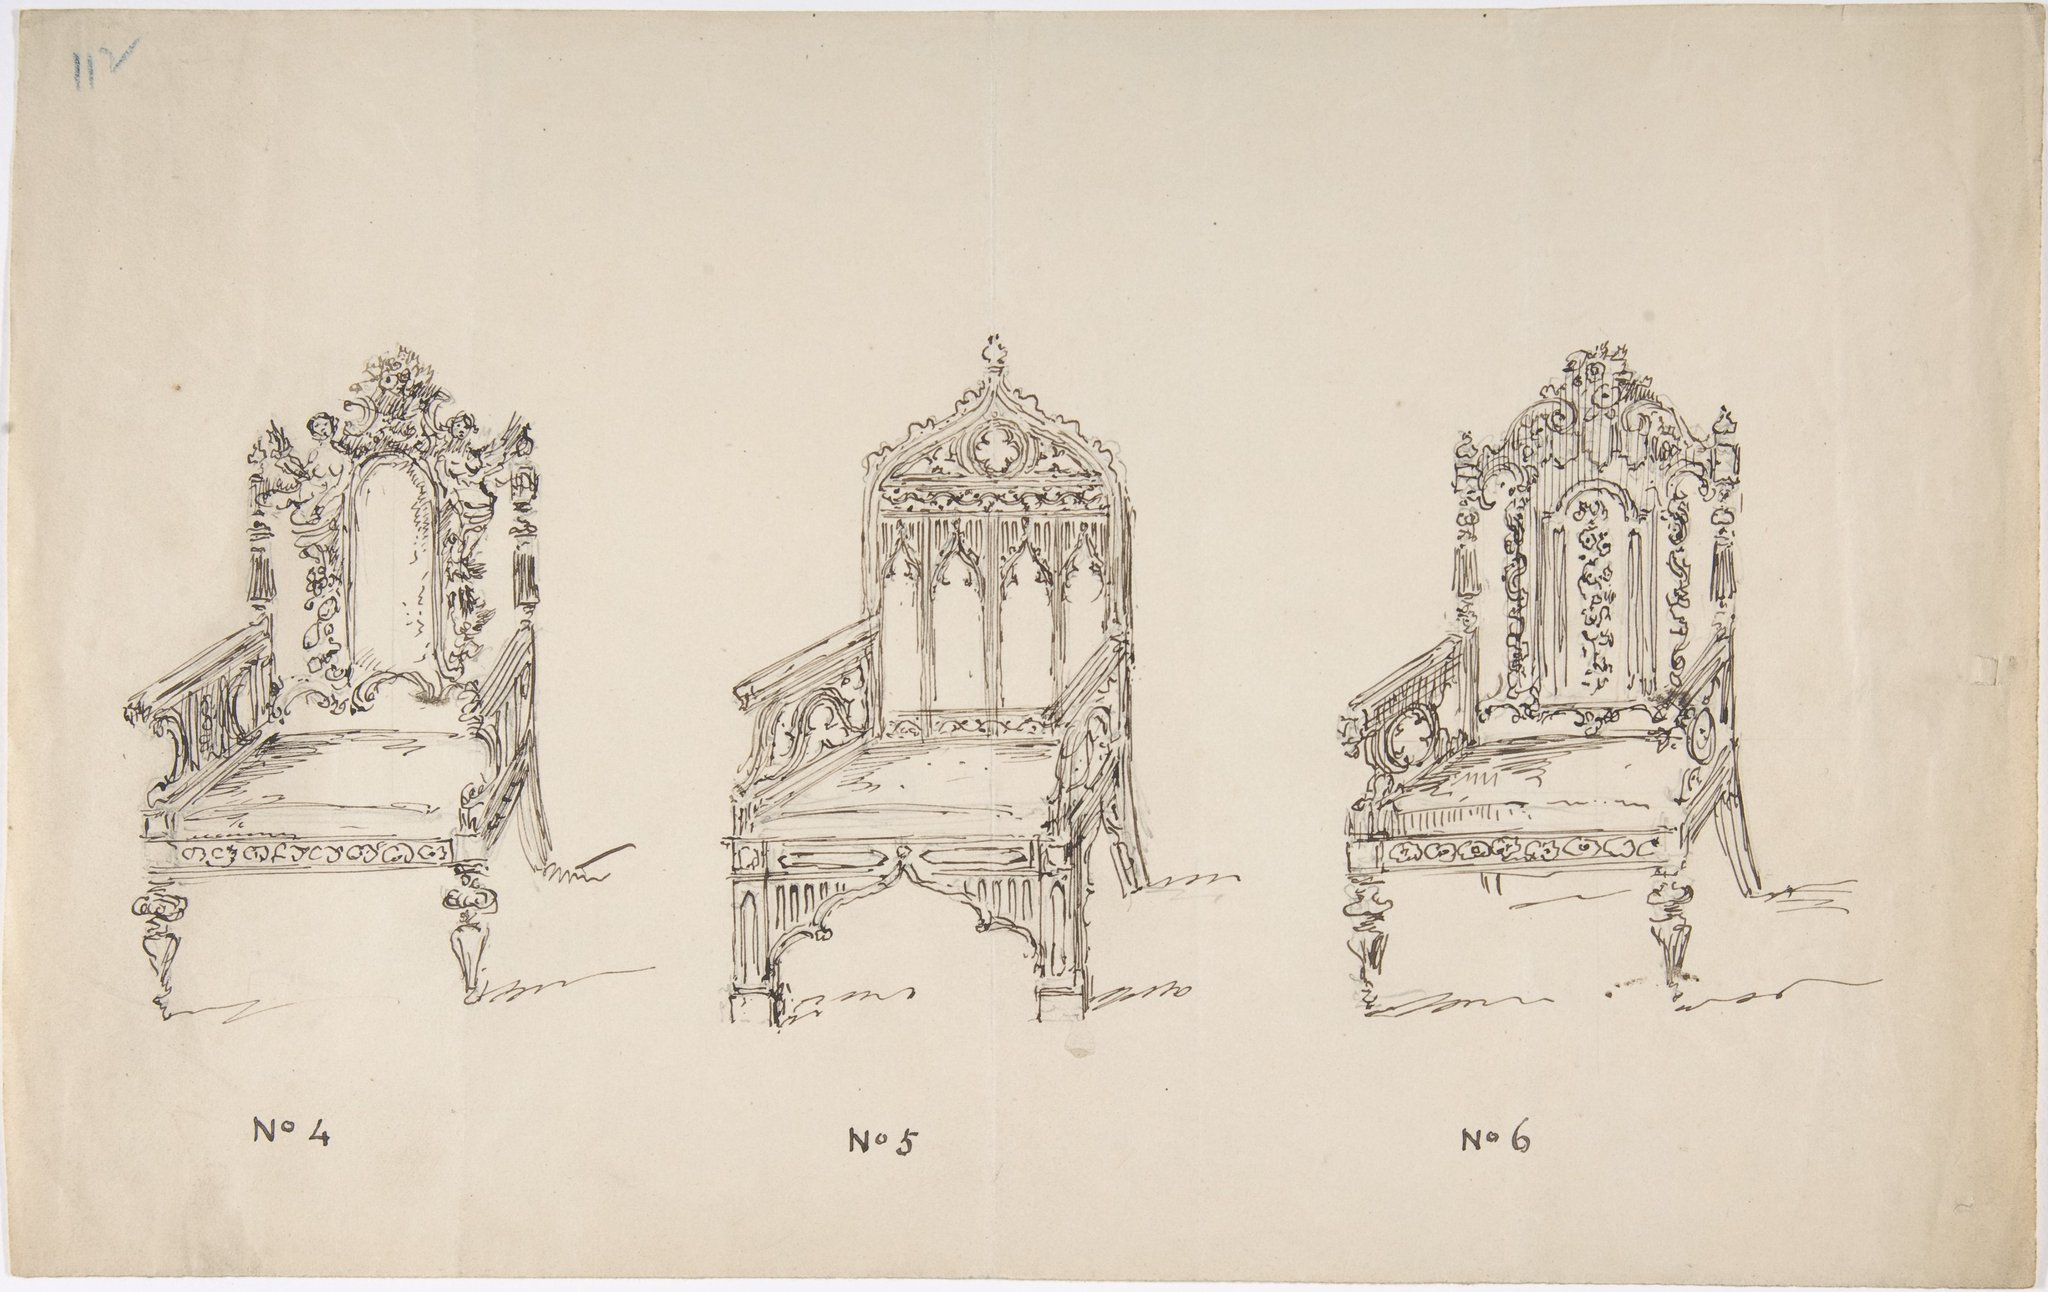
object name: drawing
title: Design for Three Low Gothic or Renaissance Style Arm Chairs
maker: anonymous, british, 19th century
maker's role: artist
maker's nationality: british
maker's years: 1800-1900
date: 1801-1833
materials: ink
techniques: pen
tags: chairs